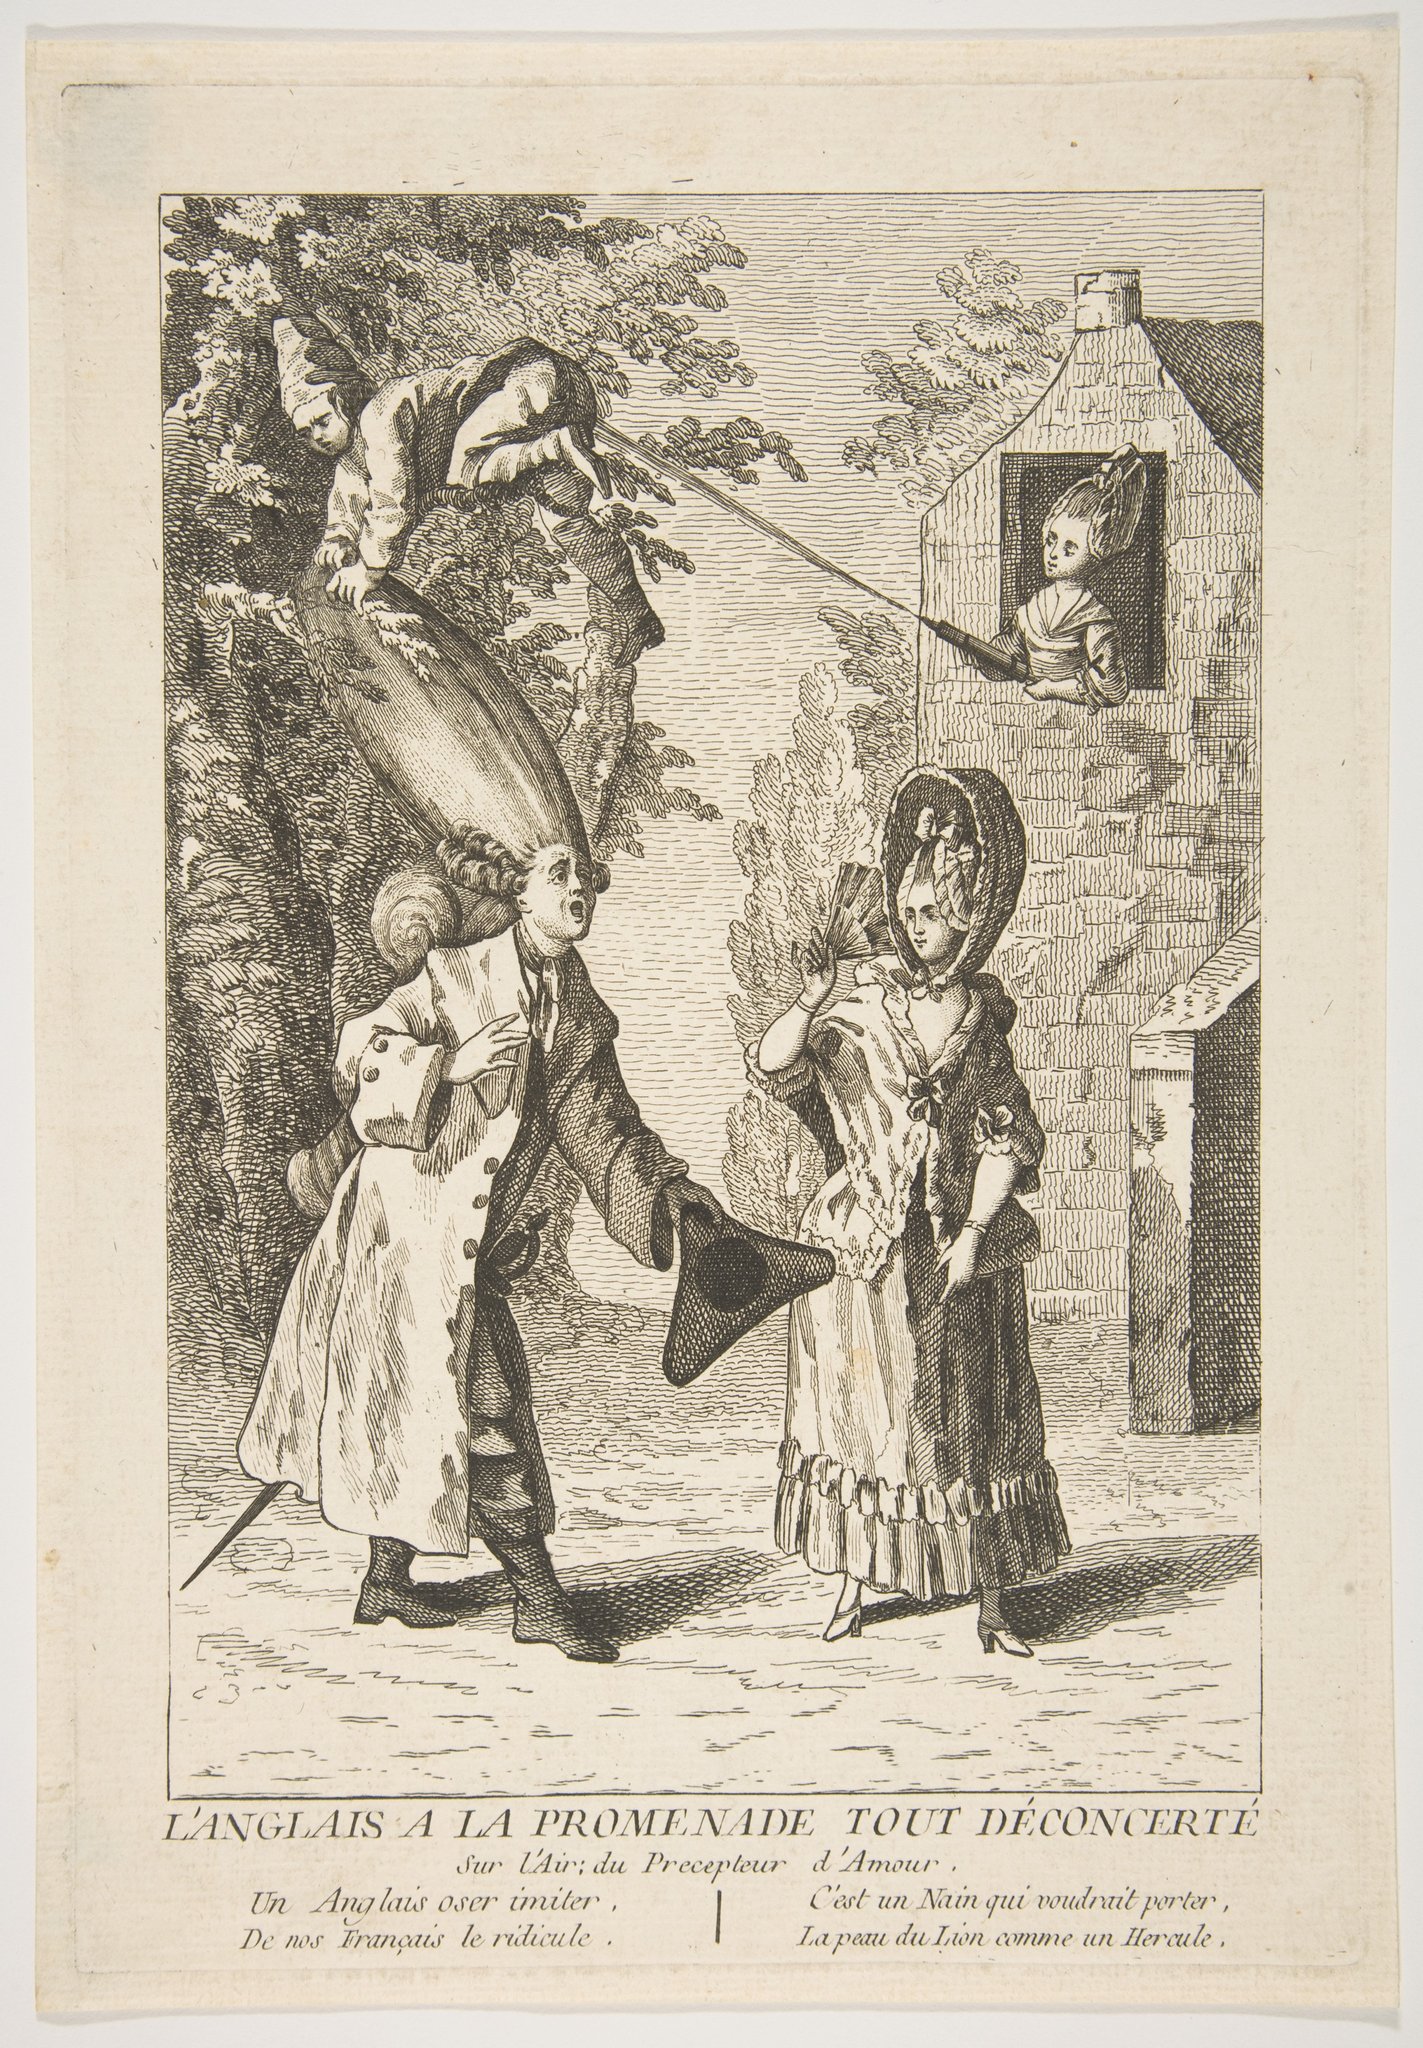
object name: print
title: L'Anglais a la Promenade Tout Déconcerté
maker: anonymous, french, 18th century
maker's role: artist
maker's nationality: french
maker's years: 1700-1800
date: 1720-1775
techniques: etching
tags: men,women,trees